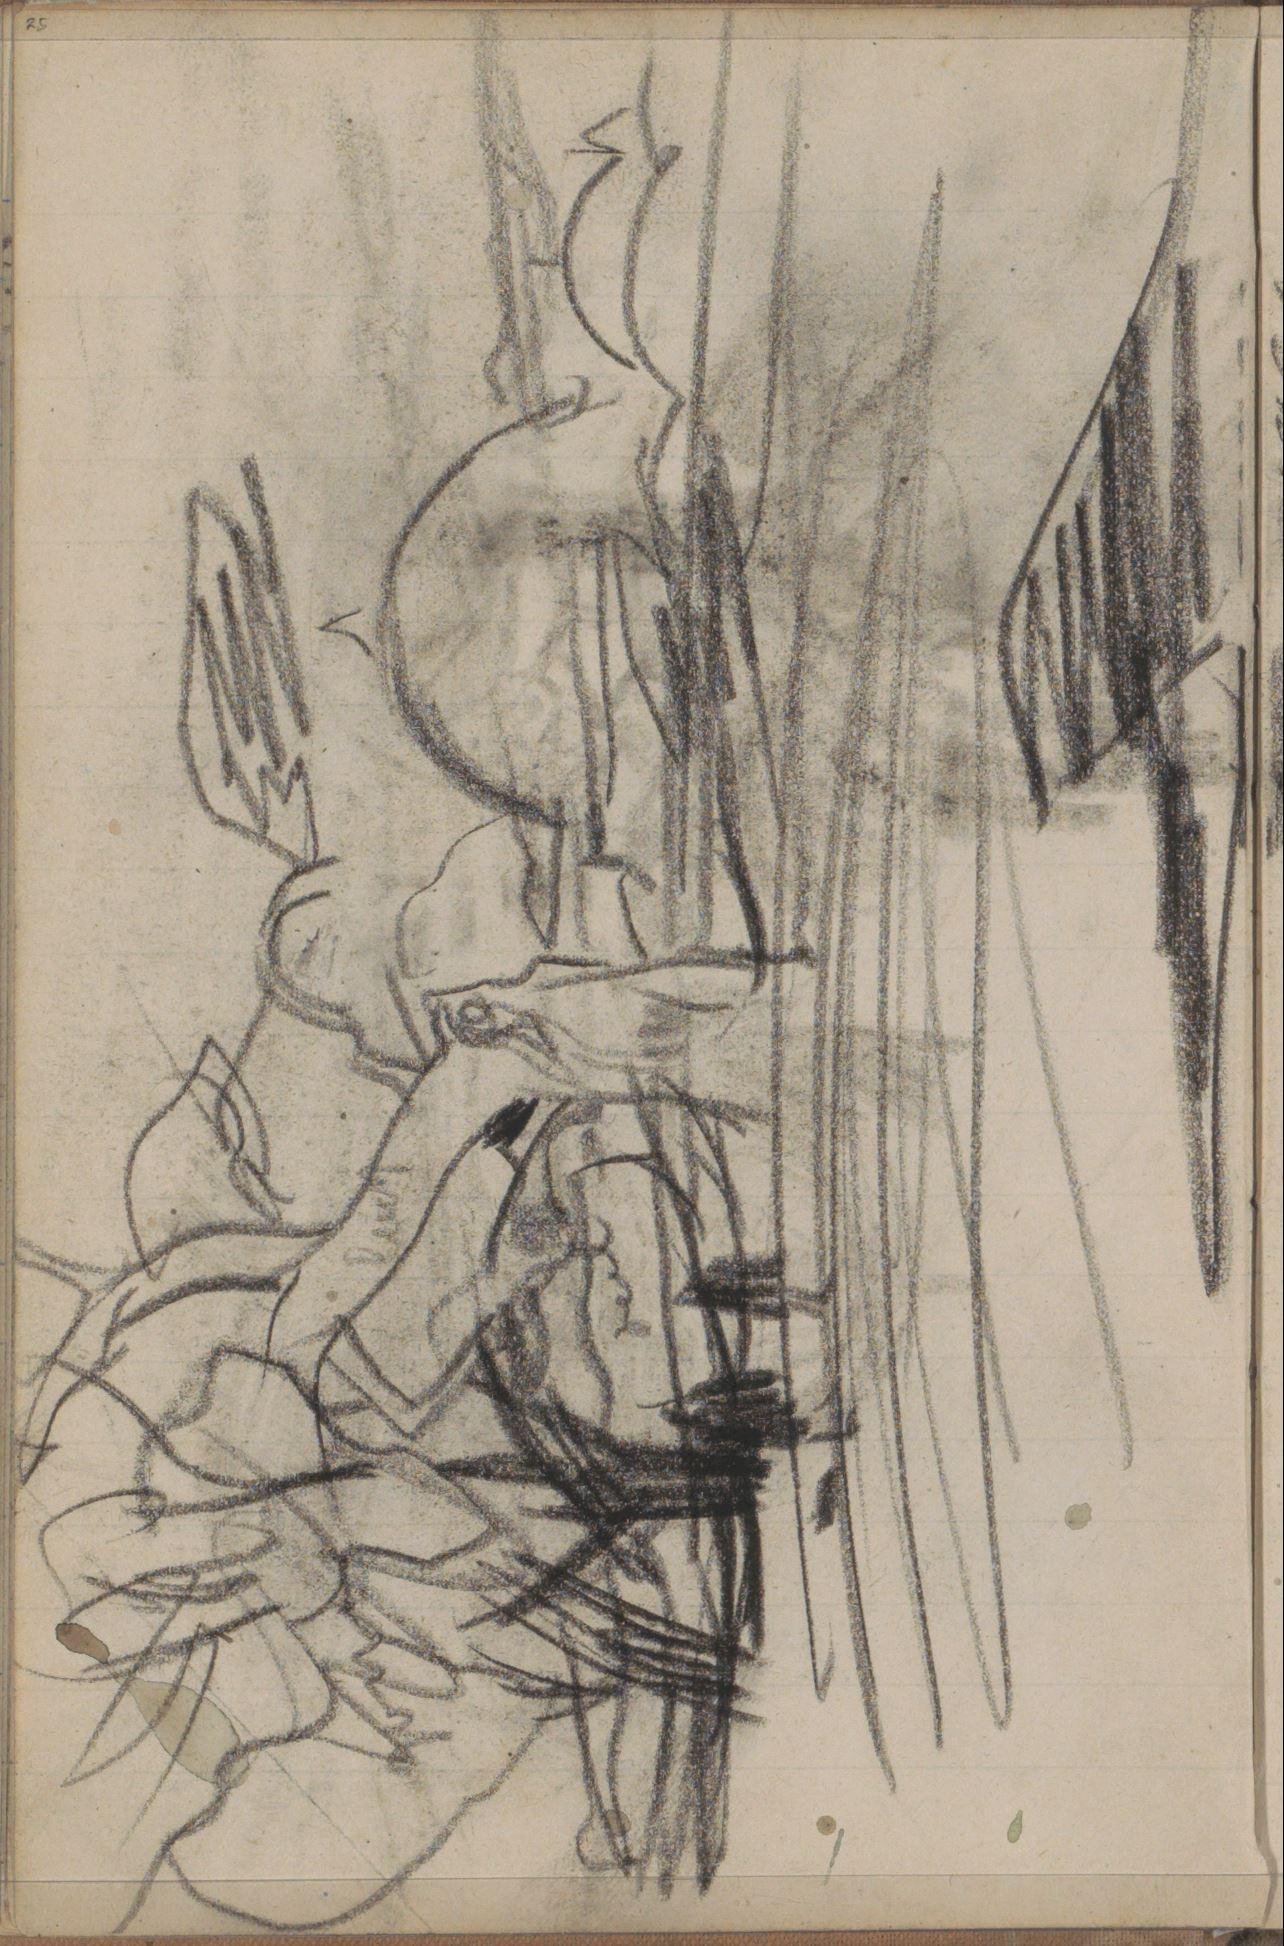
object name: sketchbook leaf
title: Landschap met een boom en koepels van een moskee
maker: marius bauer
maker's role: draughtsman, print maker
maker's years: 1867-1932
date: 1888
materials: chalk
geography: istanbul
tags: city-view, and landscape with man-made constructions, trees, temple, shrine ~ islam, mohammedanism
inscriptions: kleurnotitie, handgeschreven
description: Onder de boom enkele figuren. Pagina 25 uit een schetsboek met 56 bladen.